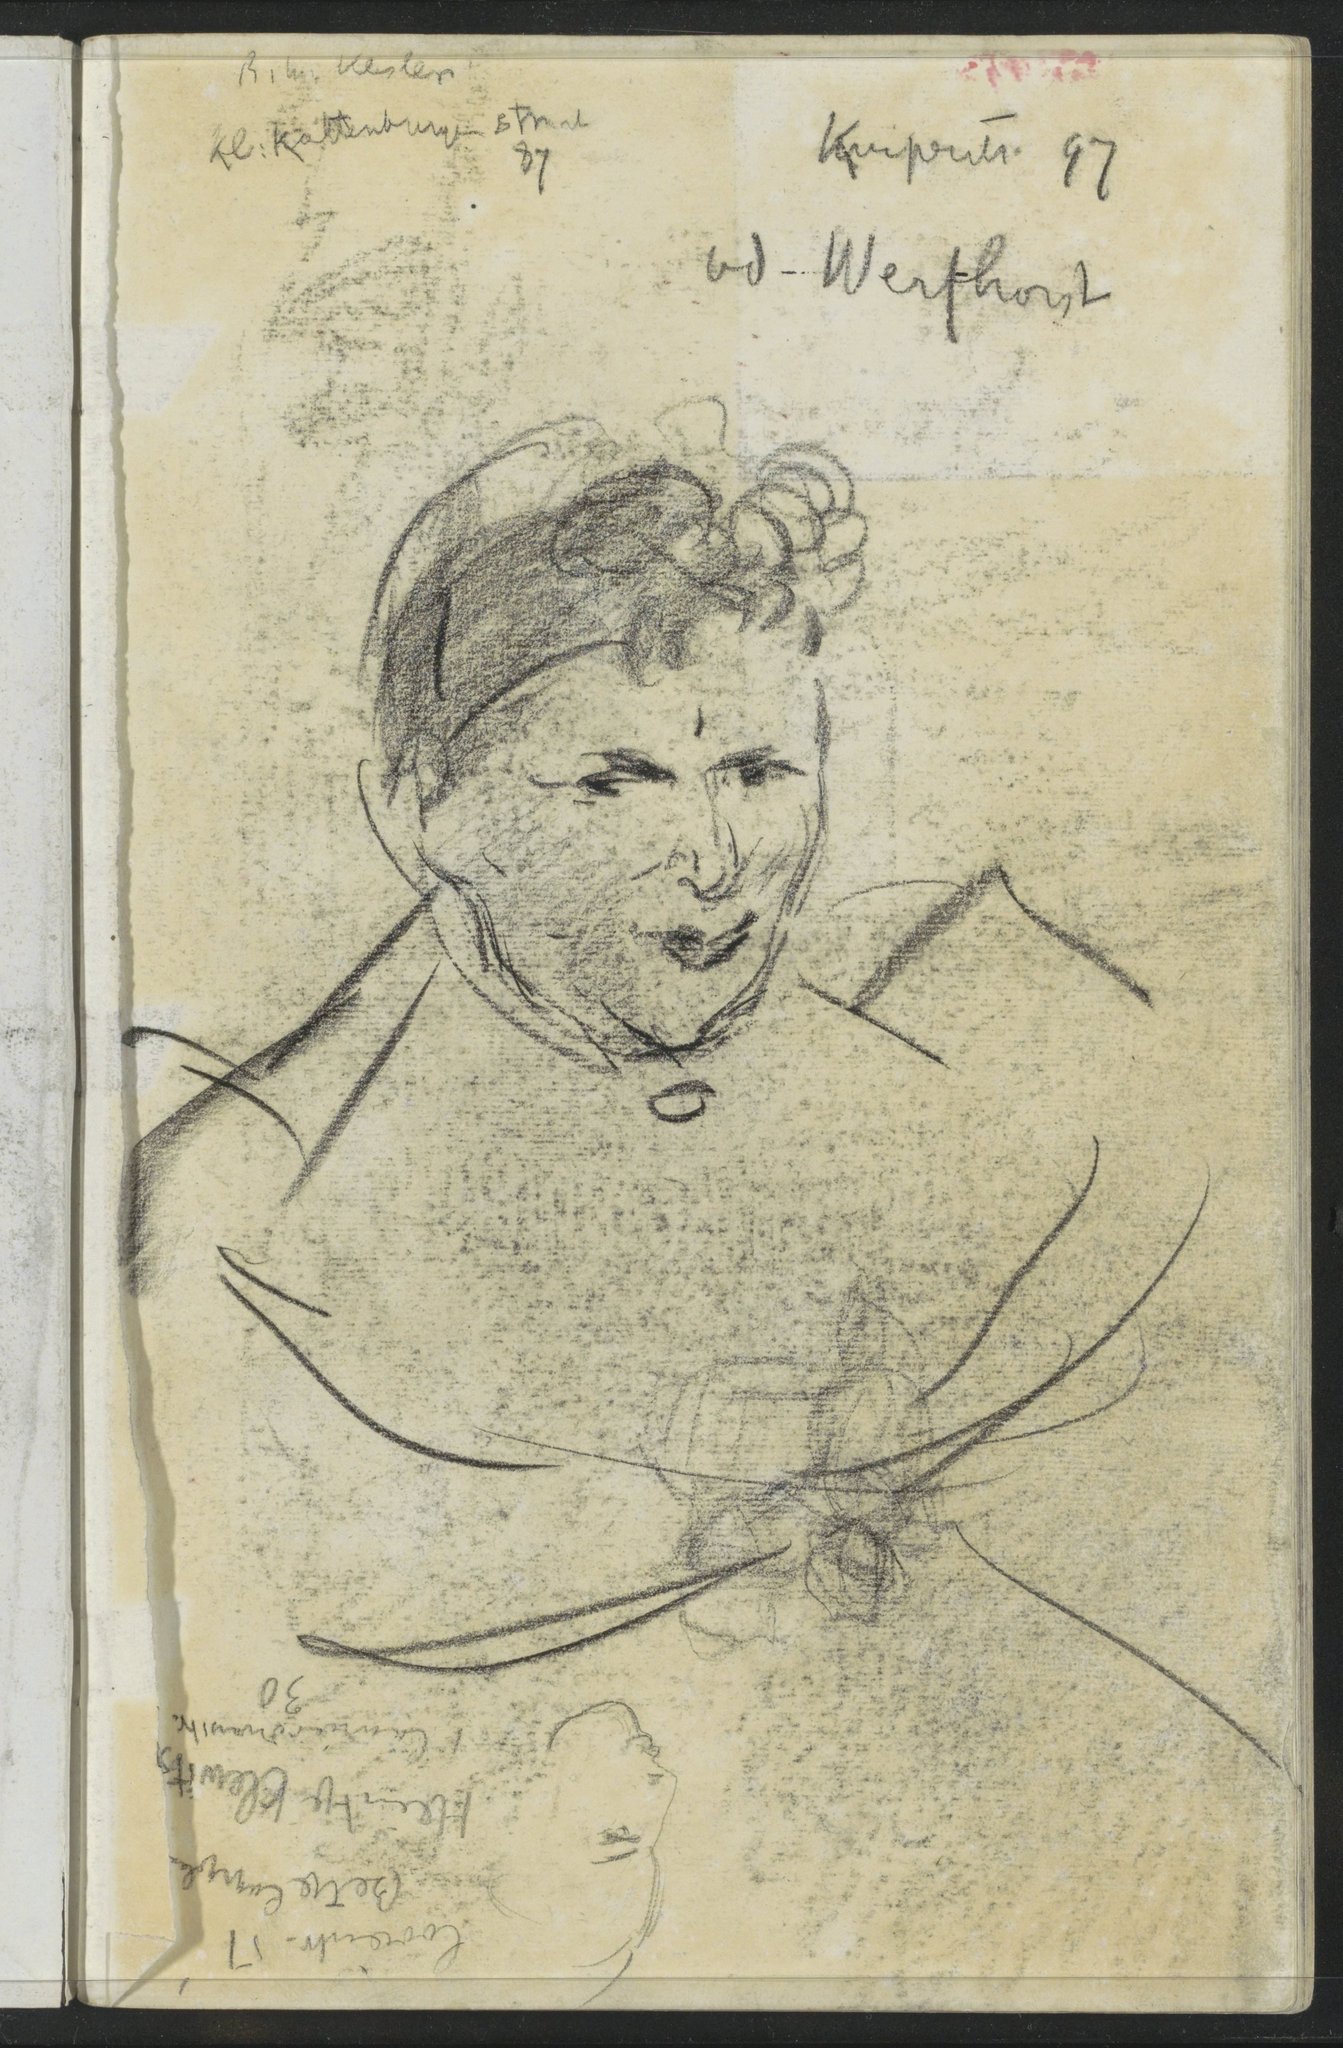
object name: sketchbook leaf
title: Vrouwenhoofden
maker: isaac israels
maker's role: draughtsman, painter, print maker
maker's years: 1865-1934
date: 1875-1934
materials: chalk, paper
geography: amsterdam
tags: head (human) - aa - female human figure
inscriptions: annotation: ‘Ri[...] Kesler / Kl. Kattenburgerstraat / 87 / Kuiperstr. 97 / vd Werfhorst / Looierstr. 17 / Betje Capplaan[?] / Heintje Clewits / 1 Laurierdwardwarsstr. / 30’, watermark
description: Blad 1 recto uit schetsboek XI met 30 bladen.